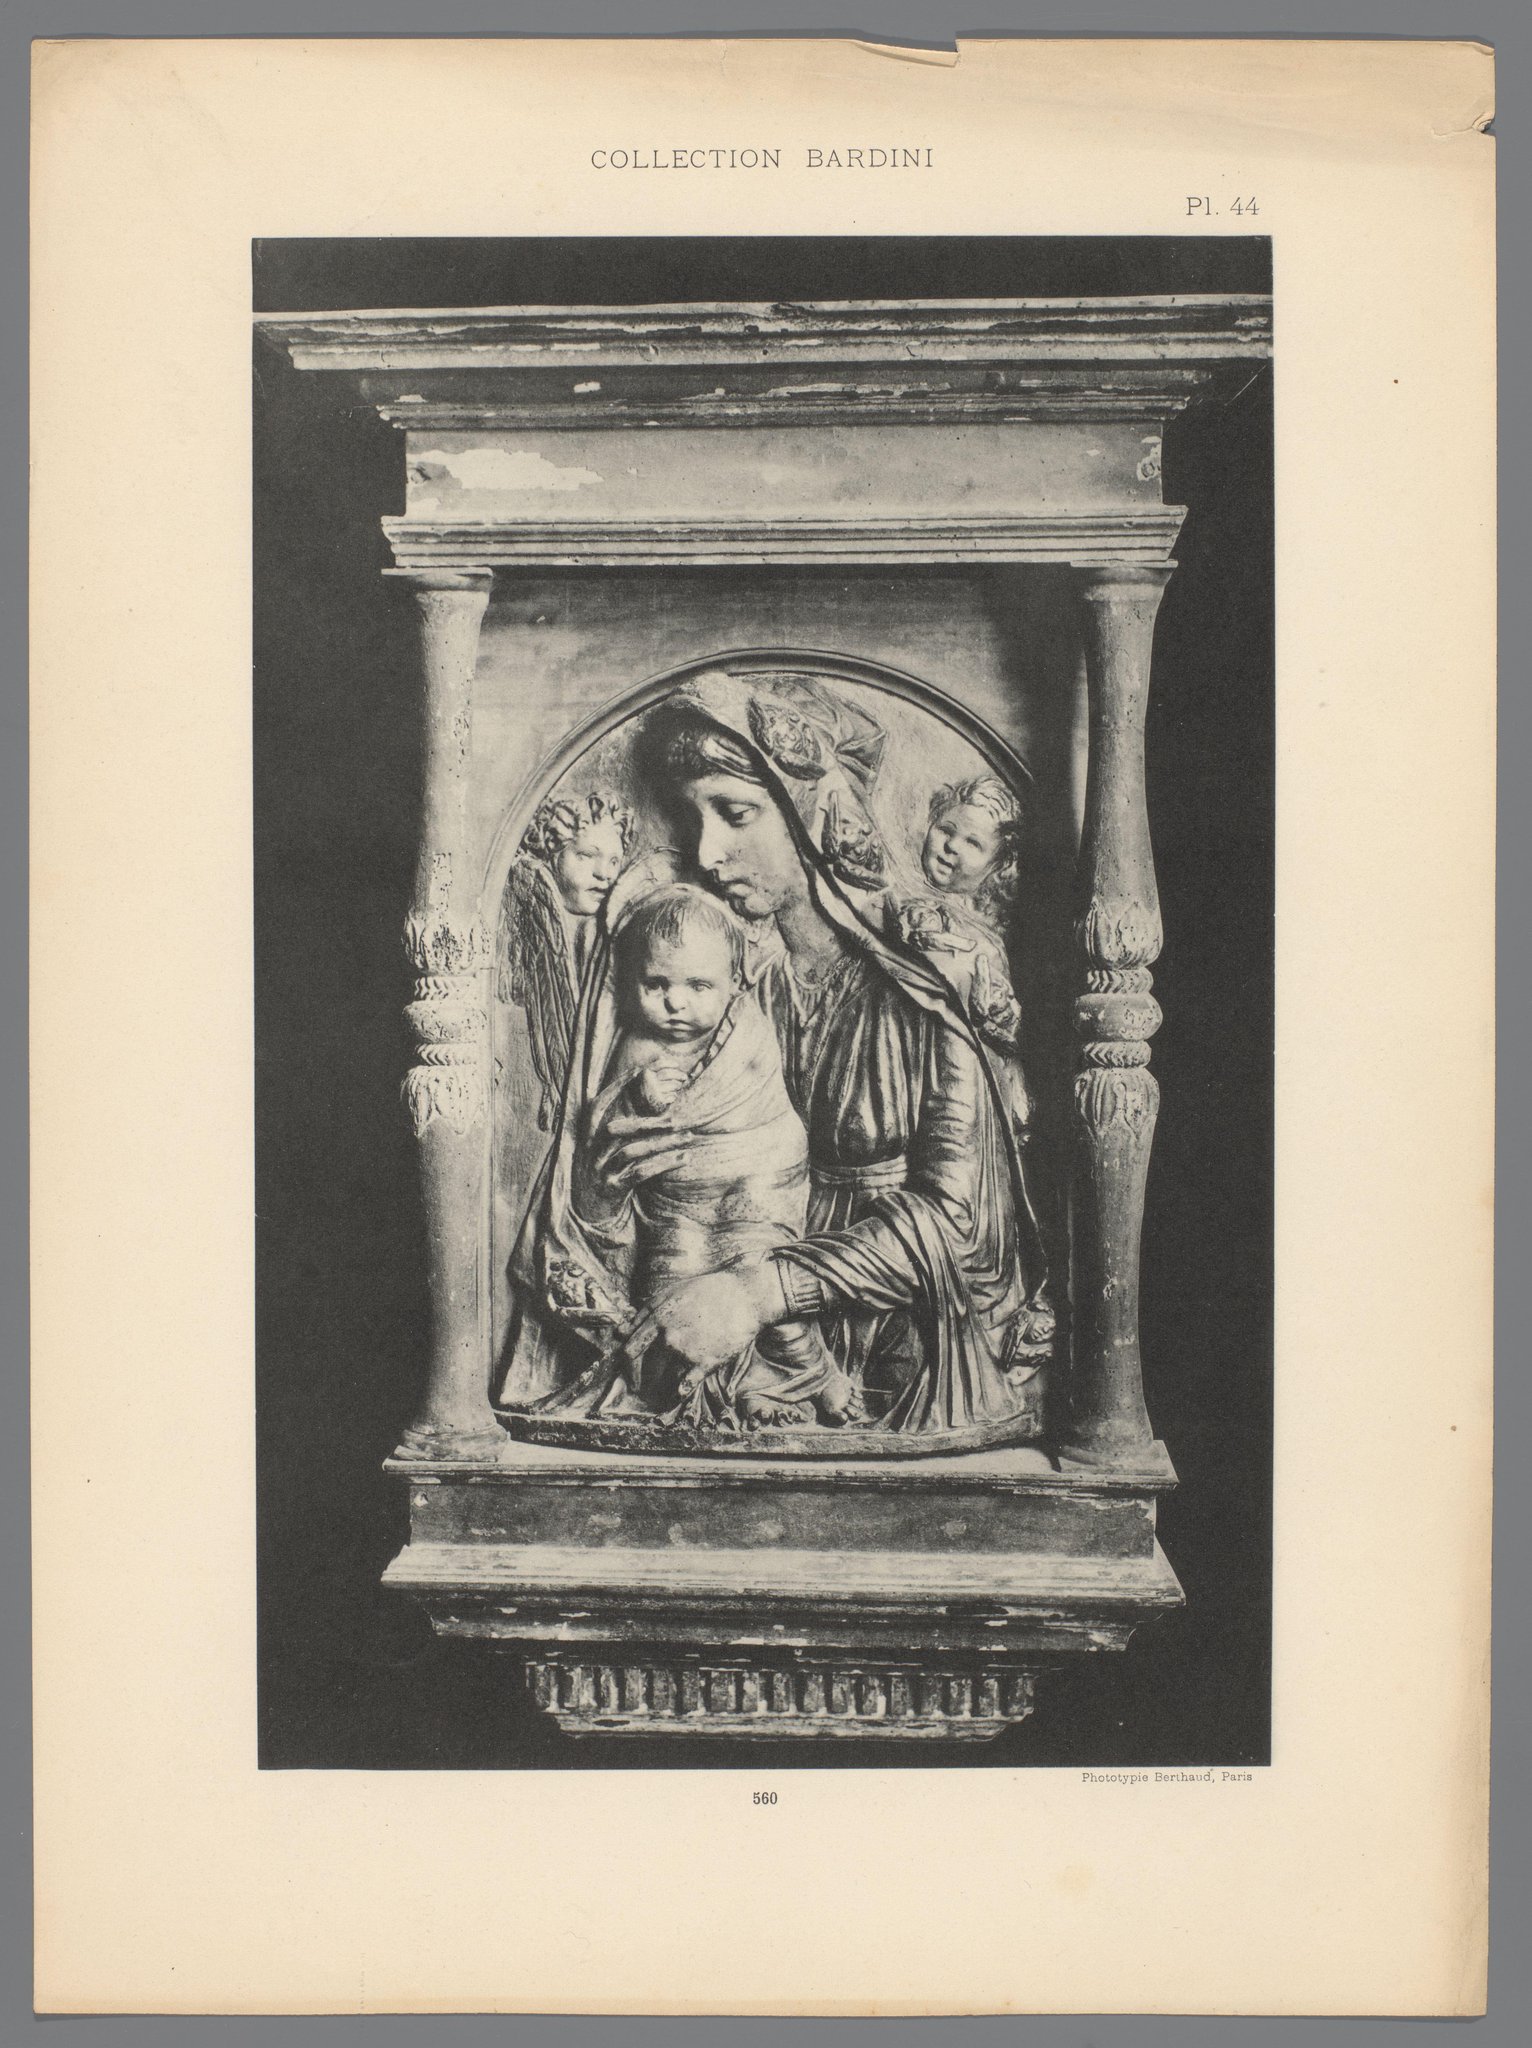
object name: photomechanical print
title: Collection Bardini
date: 1875-1912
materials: paper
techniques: photograph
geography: paris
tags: madonna: mary standing (or half-length), christ-child close to her bosom, sculpture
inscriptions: number: ‘Pl. 44’